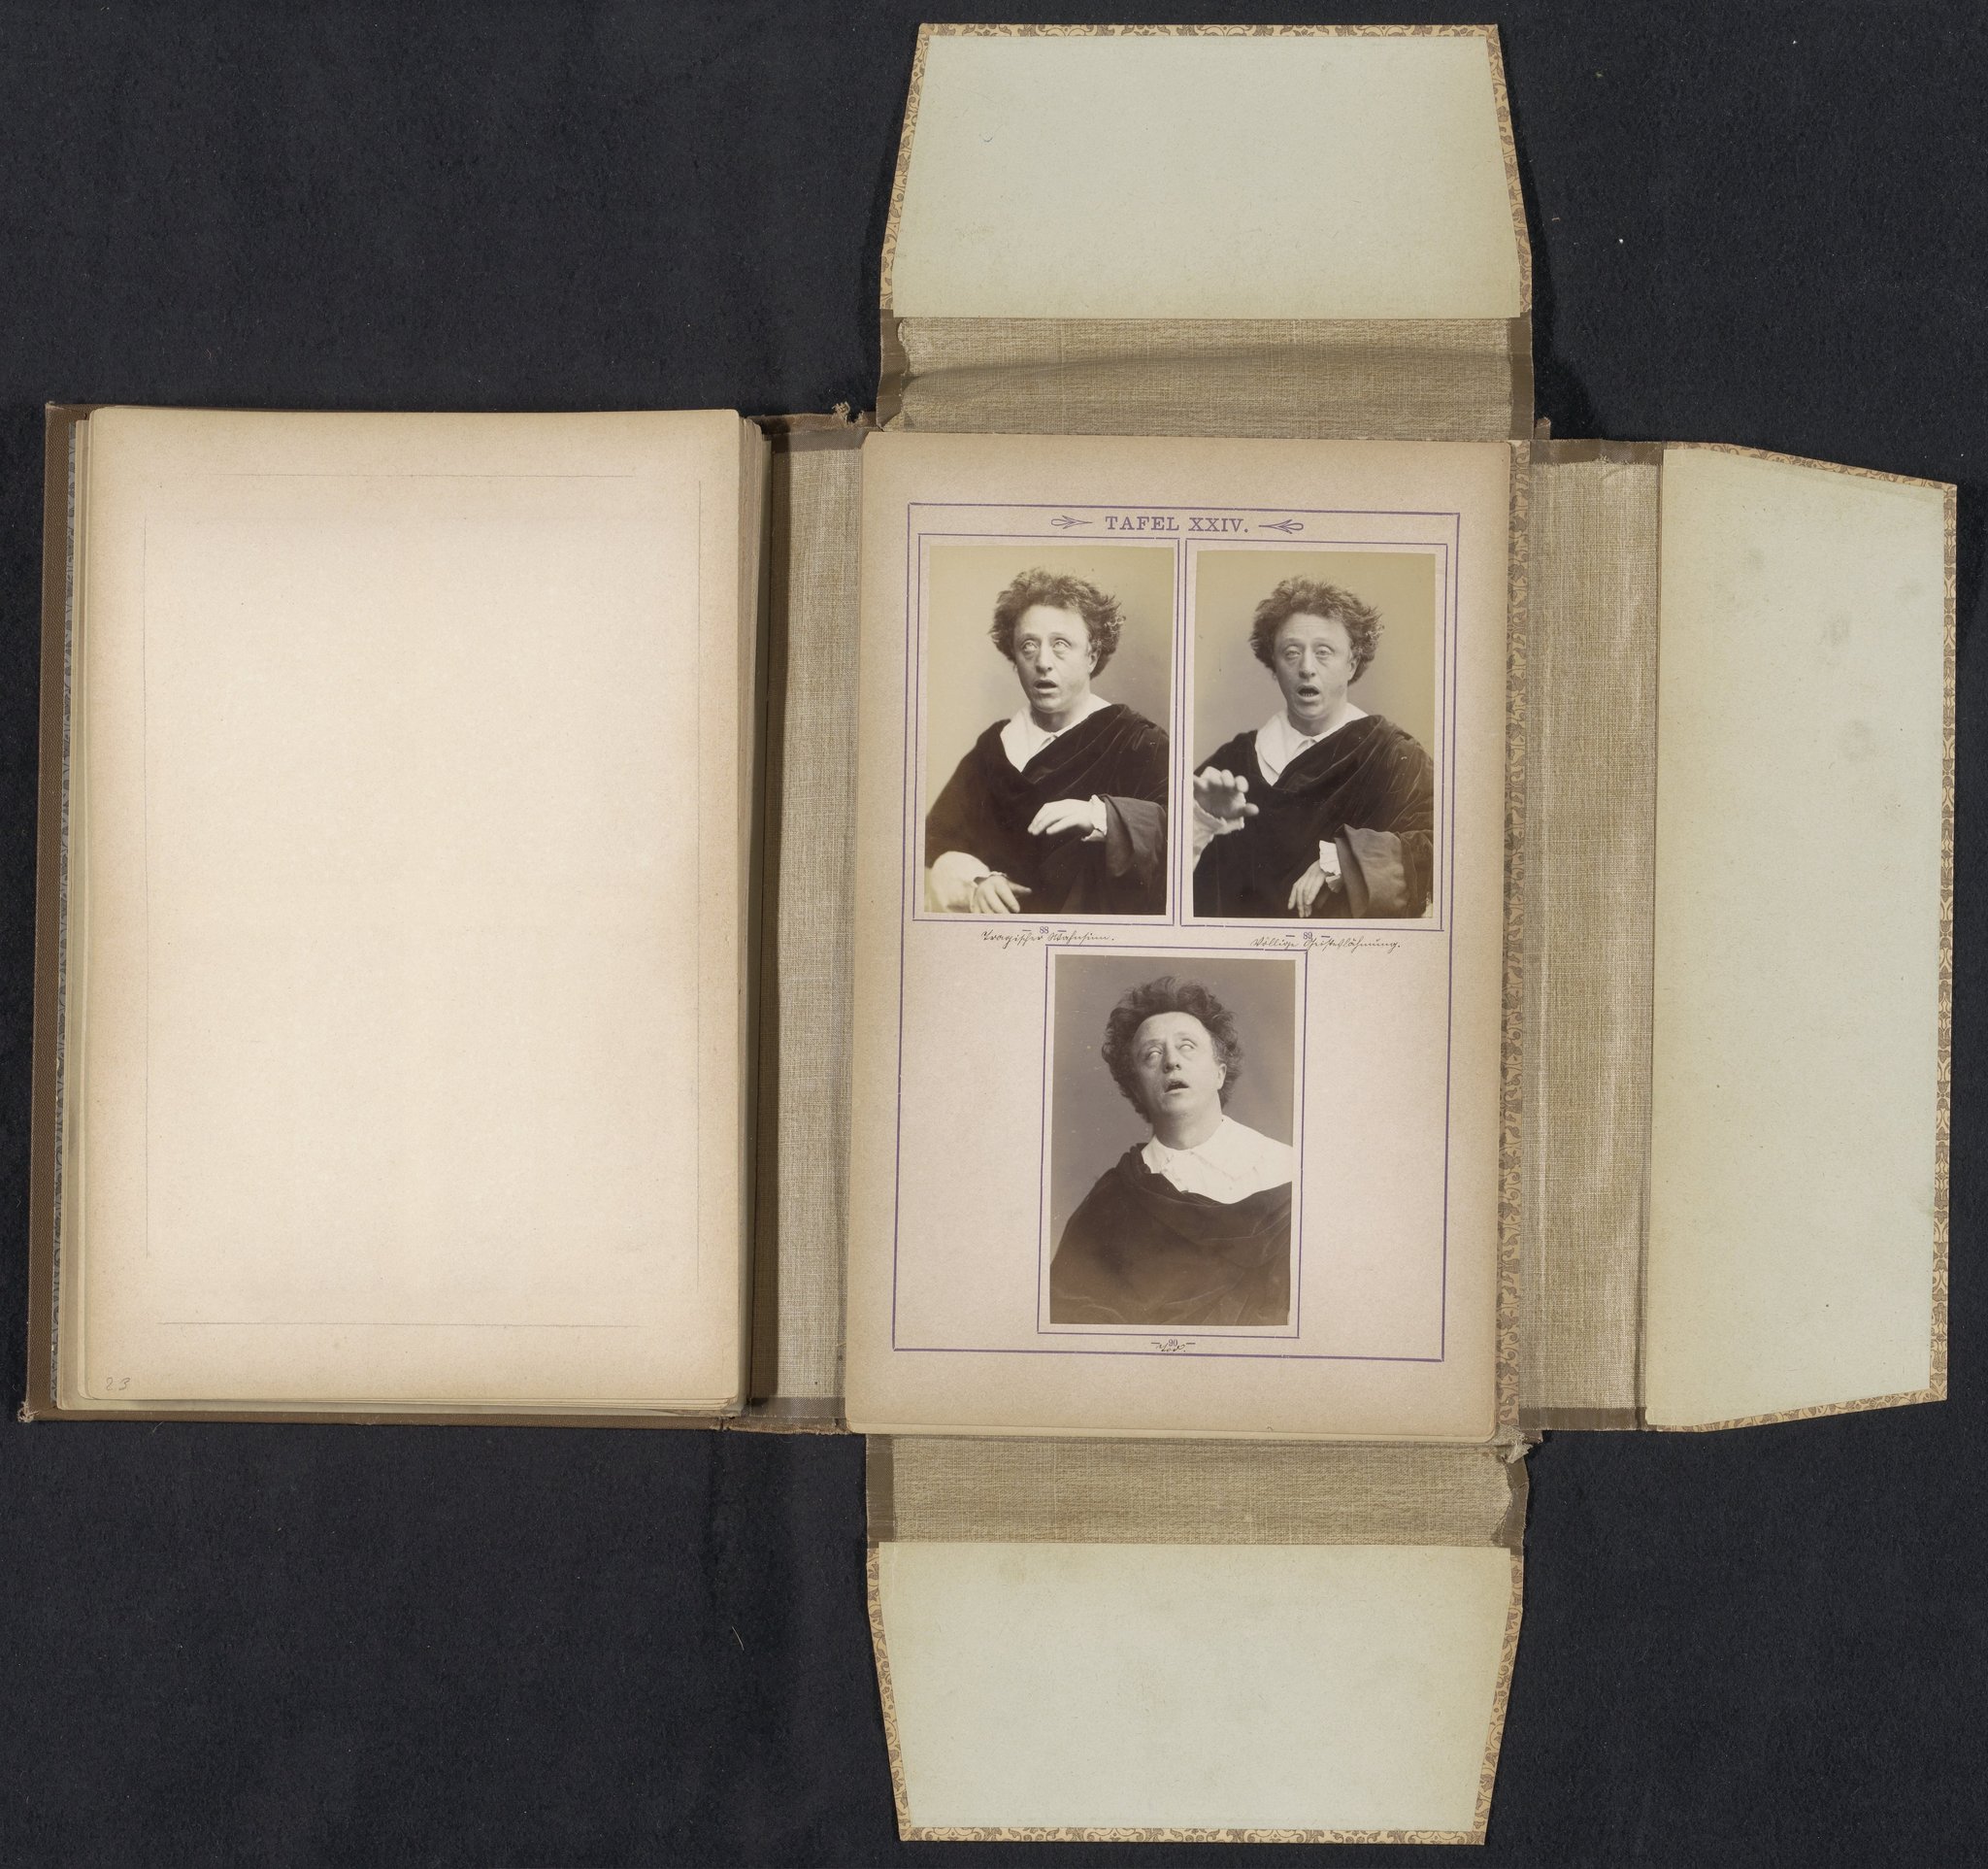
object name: photograph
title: Drie portretten van een man met gezichtsuitdrukkingen van waanzin, geestesverlamming en de dood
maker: nicola tonger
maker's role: fotograaf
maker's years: 1846-1917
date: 1881-1886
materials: cardboard, photographic support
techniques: albumen print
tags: morphology of facial expression, madness, death of human being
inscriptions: inscription: ‘Tragischer (...) Tod.’, number: ‘Tafel XXIV.’, number: ‘88 (...) 90’